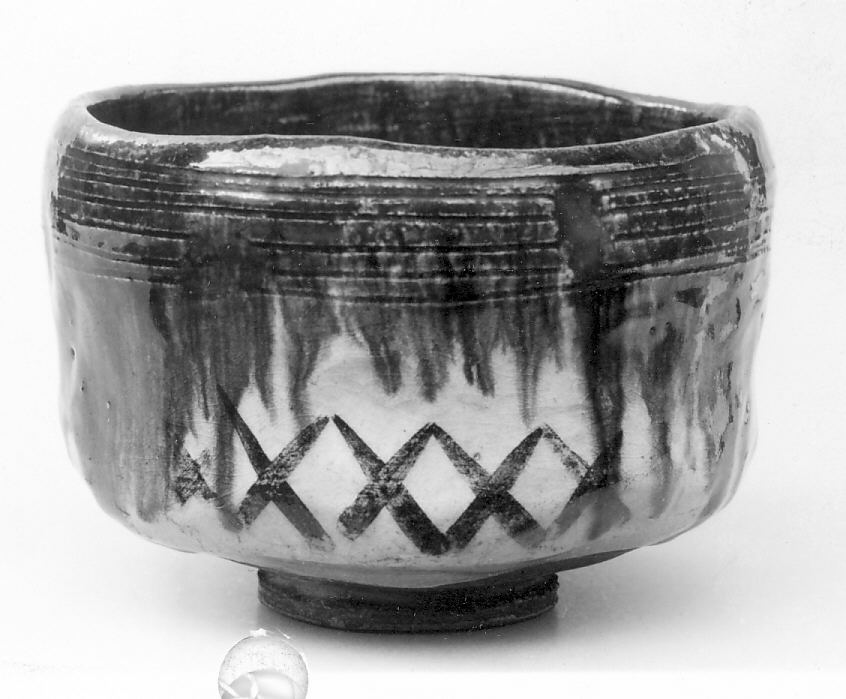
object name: teabowl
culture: japanese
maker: keinyu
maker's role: artist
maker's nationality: japanese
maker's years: 1793-1893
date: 1852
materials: clay, glaze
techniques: incising, overglaze